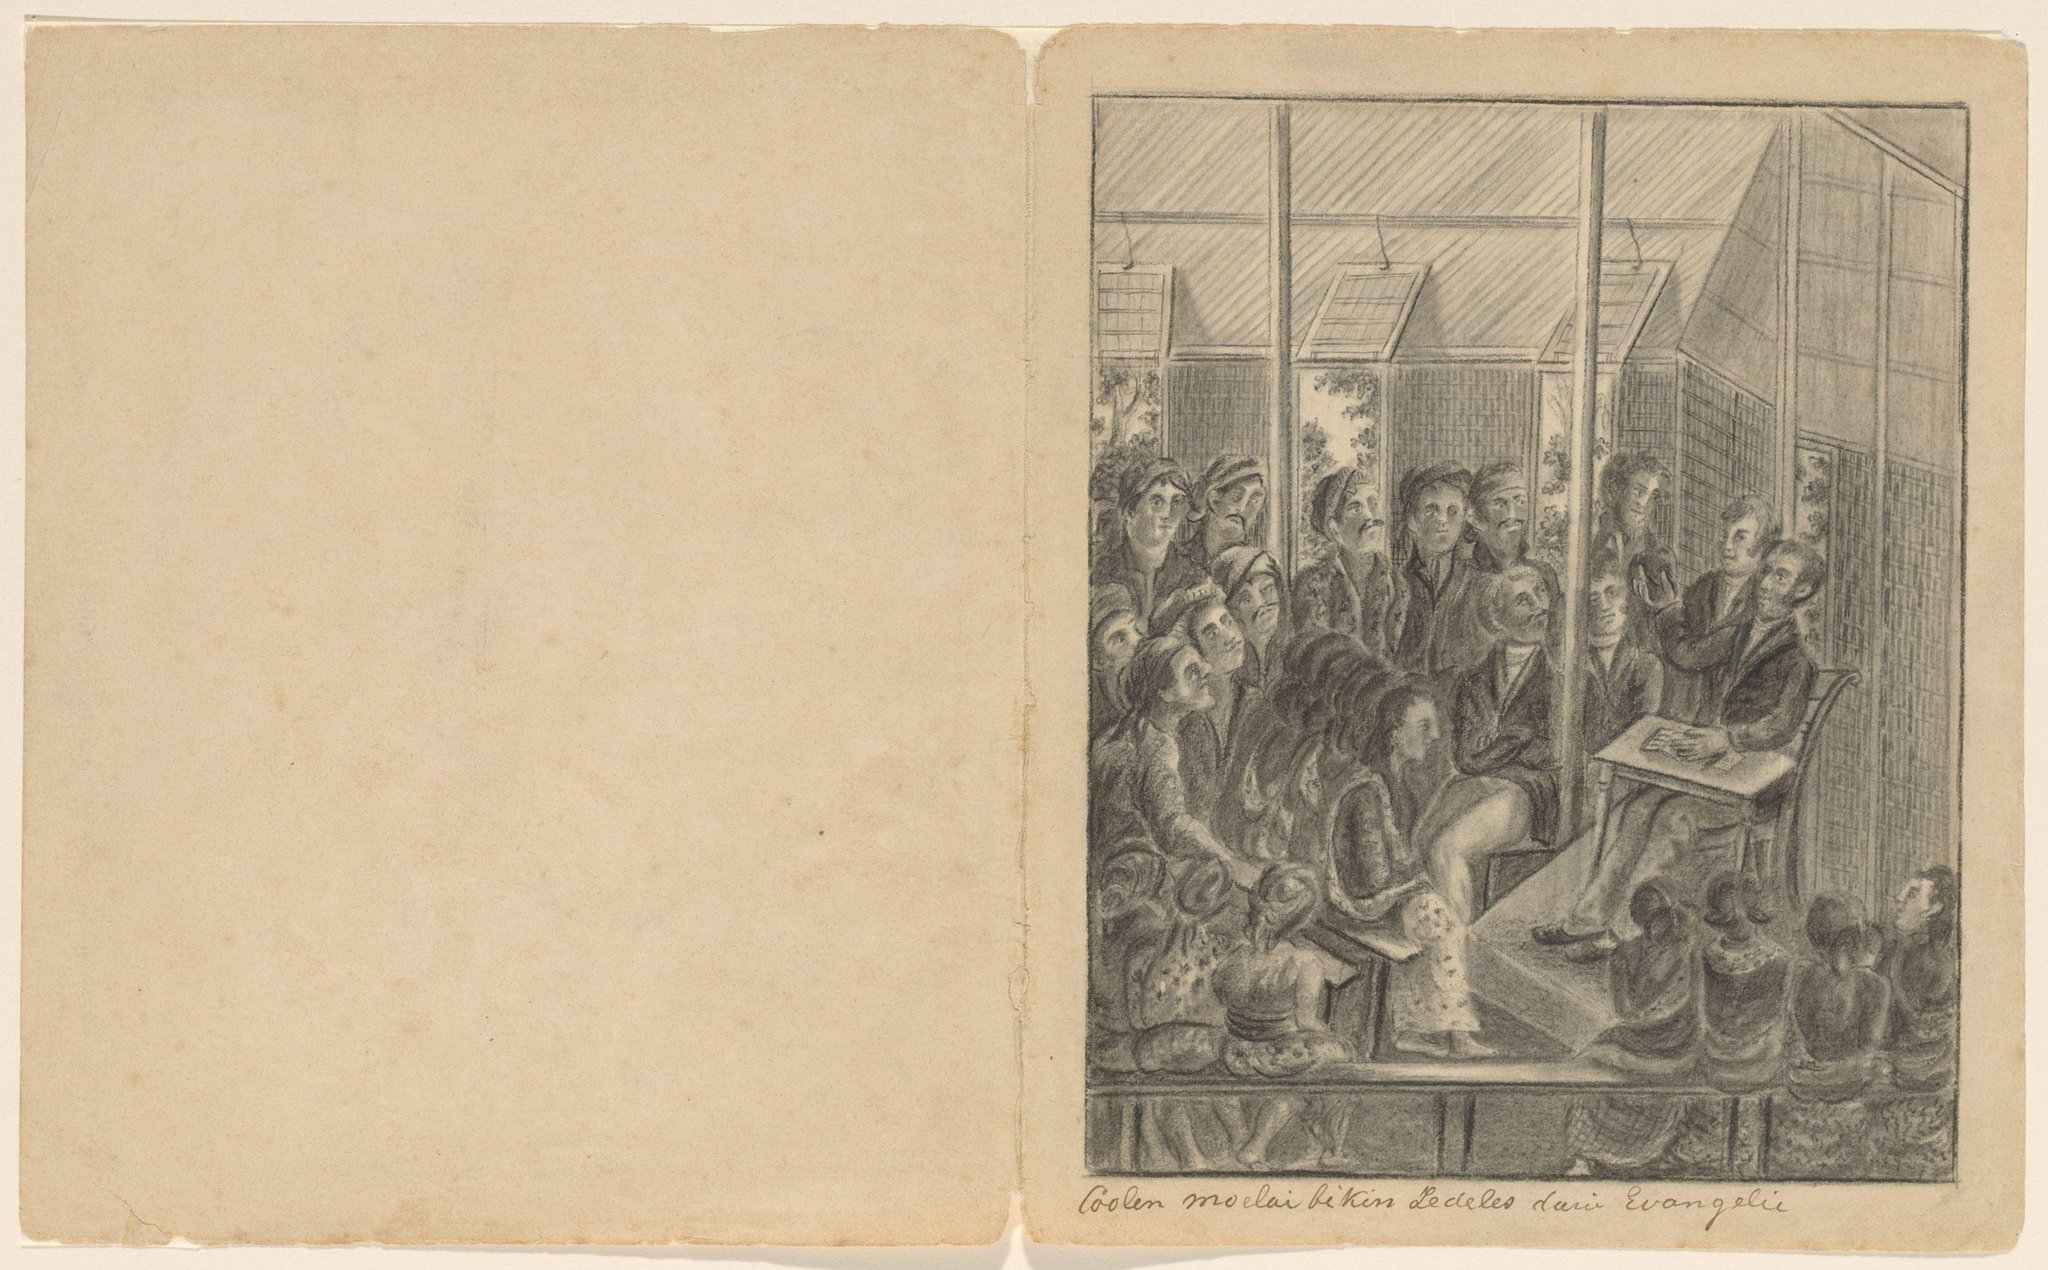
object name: drawing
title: Coolen begint met de lessen van het evangelie, ca. 1820-1850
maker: Anonymous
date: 1850-1950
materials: chalk, paper, pencil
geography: indonesia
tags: eruption (of volcano)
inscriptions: collector's mark: Lugt 2228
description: Coolen begint met de lessen van het evangelie. Onderdeel van een groep van twaalf losse bladen uit een schetsboek met tekeningen over het leven van Coenraad Laurens Coolen, evangelist op Oost-Java, ca. 1820-1850. Elk blad heeft een tekening op de rechterhelft, met een onderschrift in het Indonesisch.